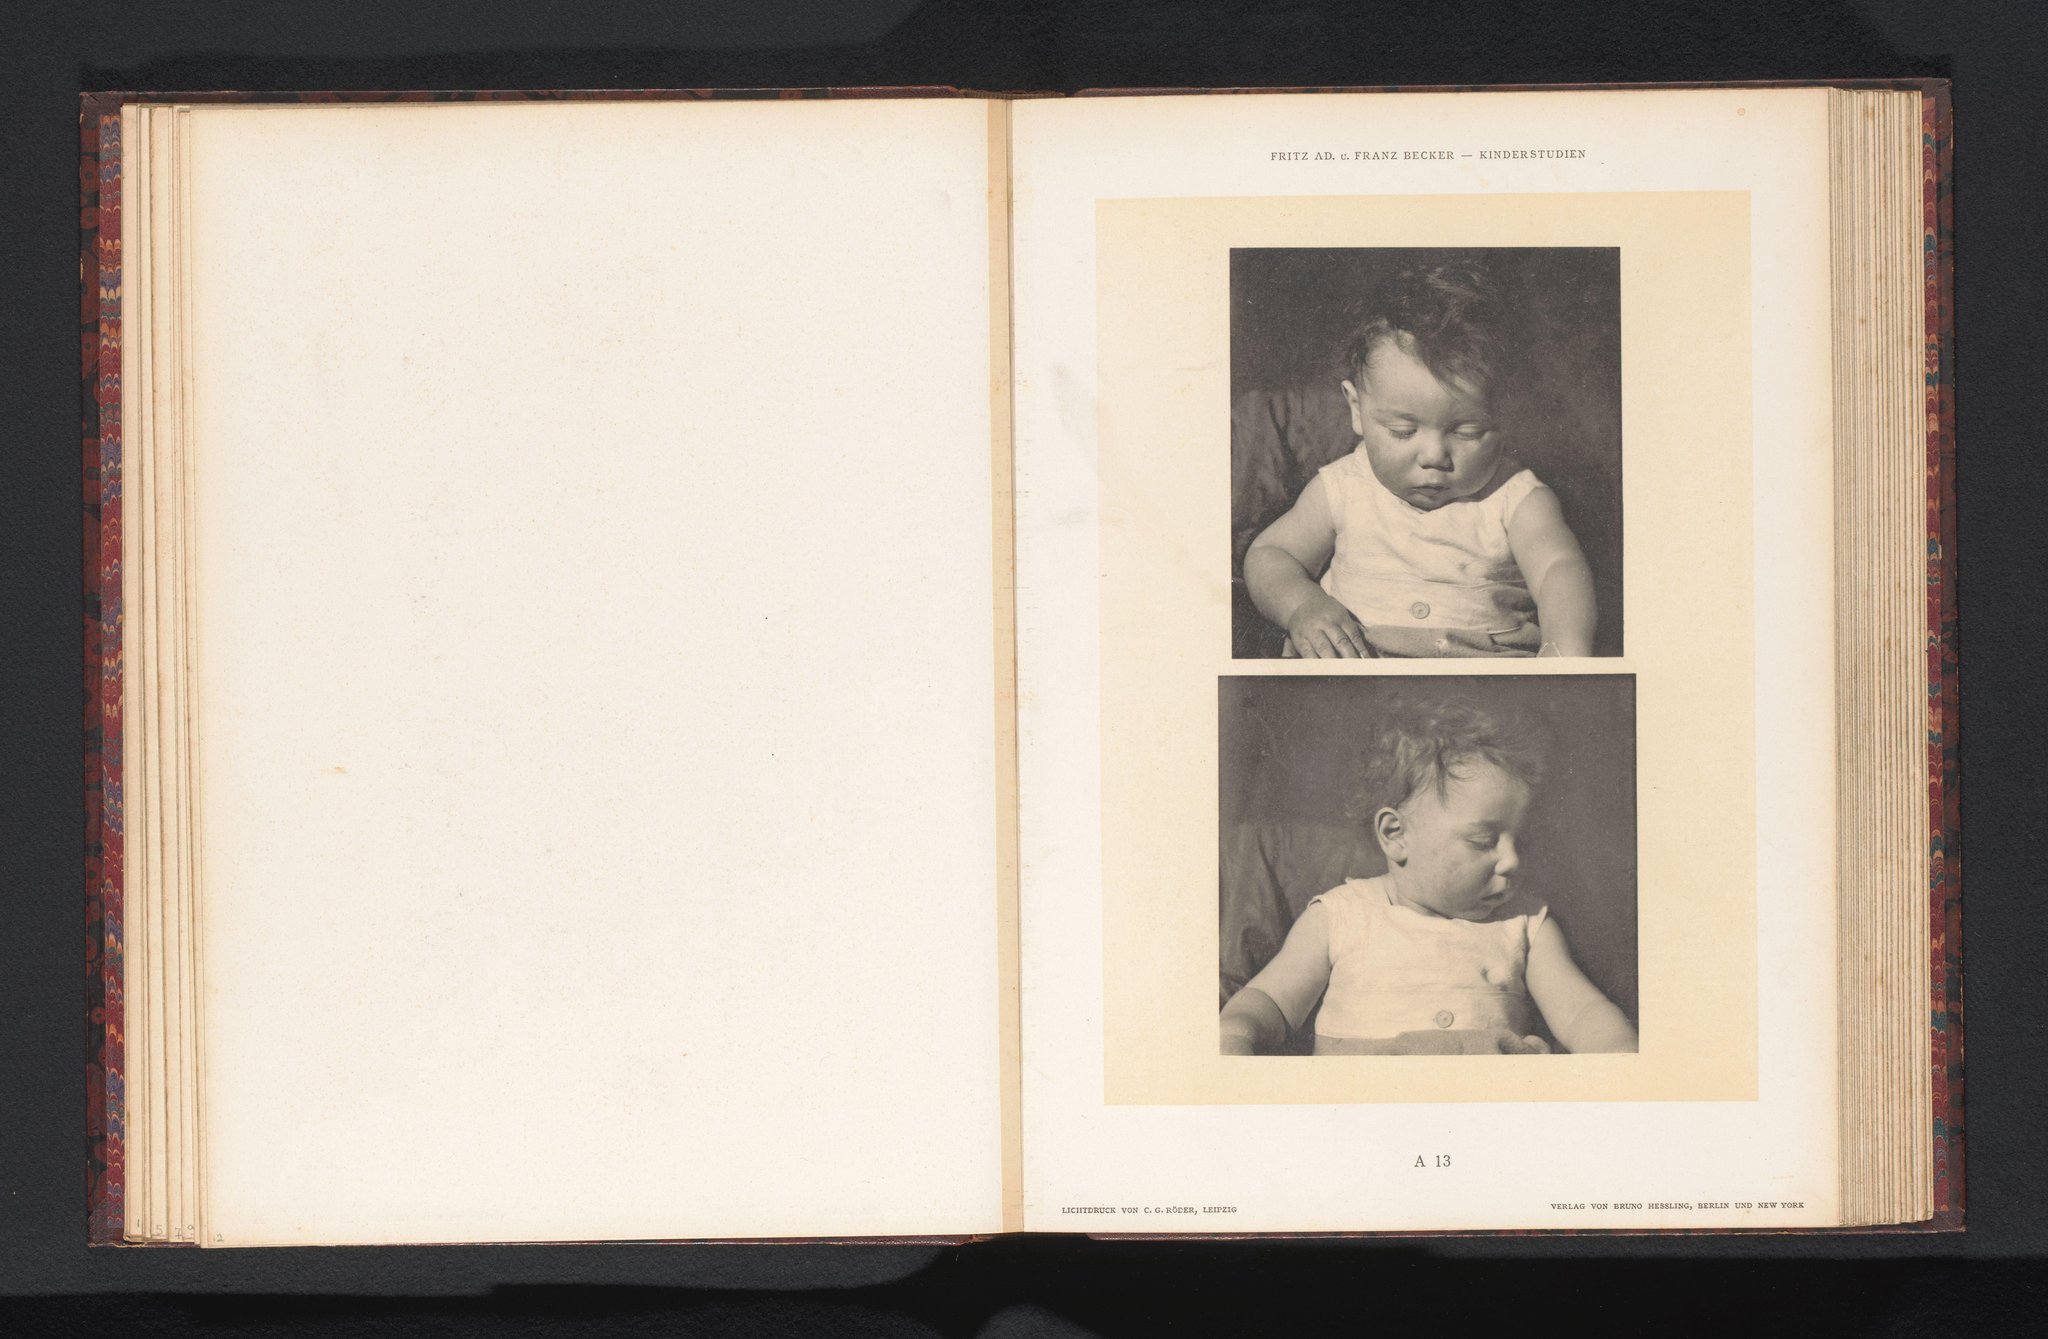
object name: page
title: Twee afbeeldingen van een zittend kind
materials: paper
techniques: photograph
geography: new york city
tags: sitting figure, tot, toddler ~ the ages of man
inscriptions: number: ‘A 13’